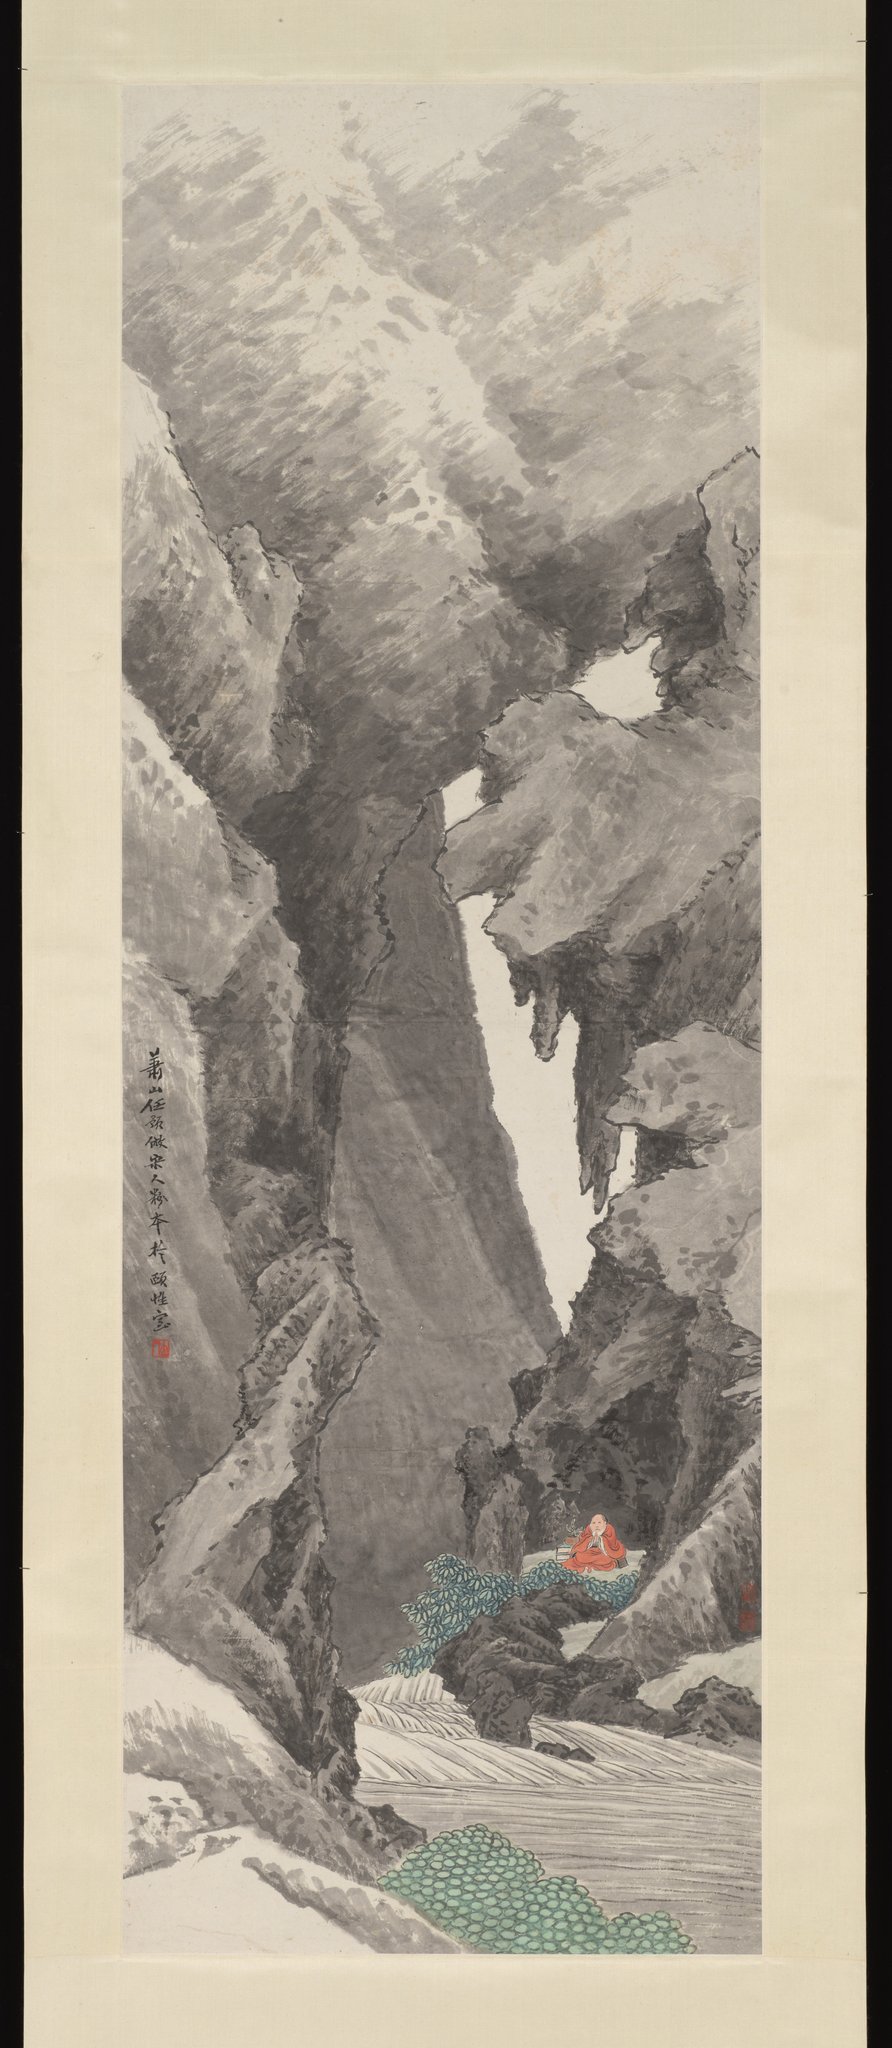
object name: hanging scroll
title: Meditation in a Cave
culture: chinese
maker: ren yu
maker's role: artist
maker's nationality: chinese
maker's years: 1853-1901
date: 1853-1901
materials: ink, paper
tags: men,caves